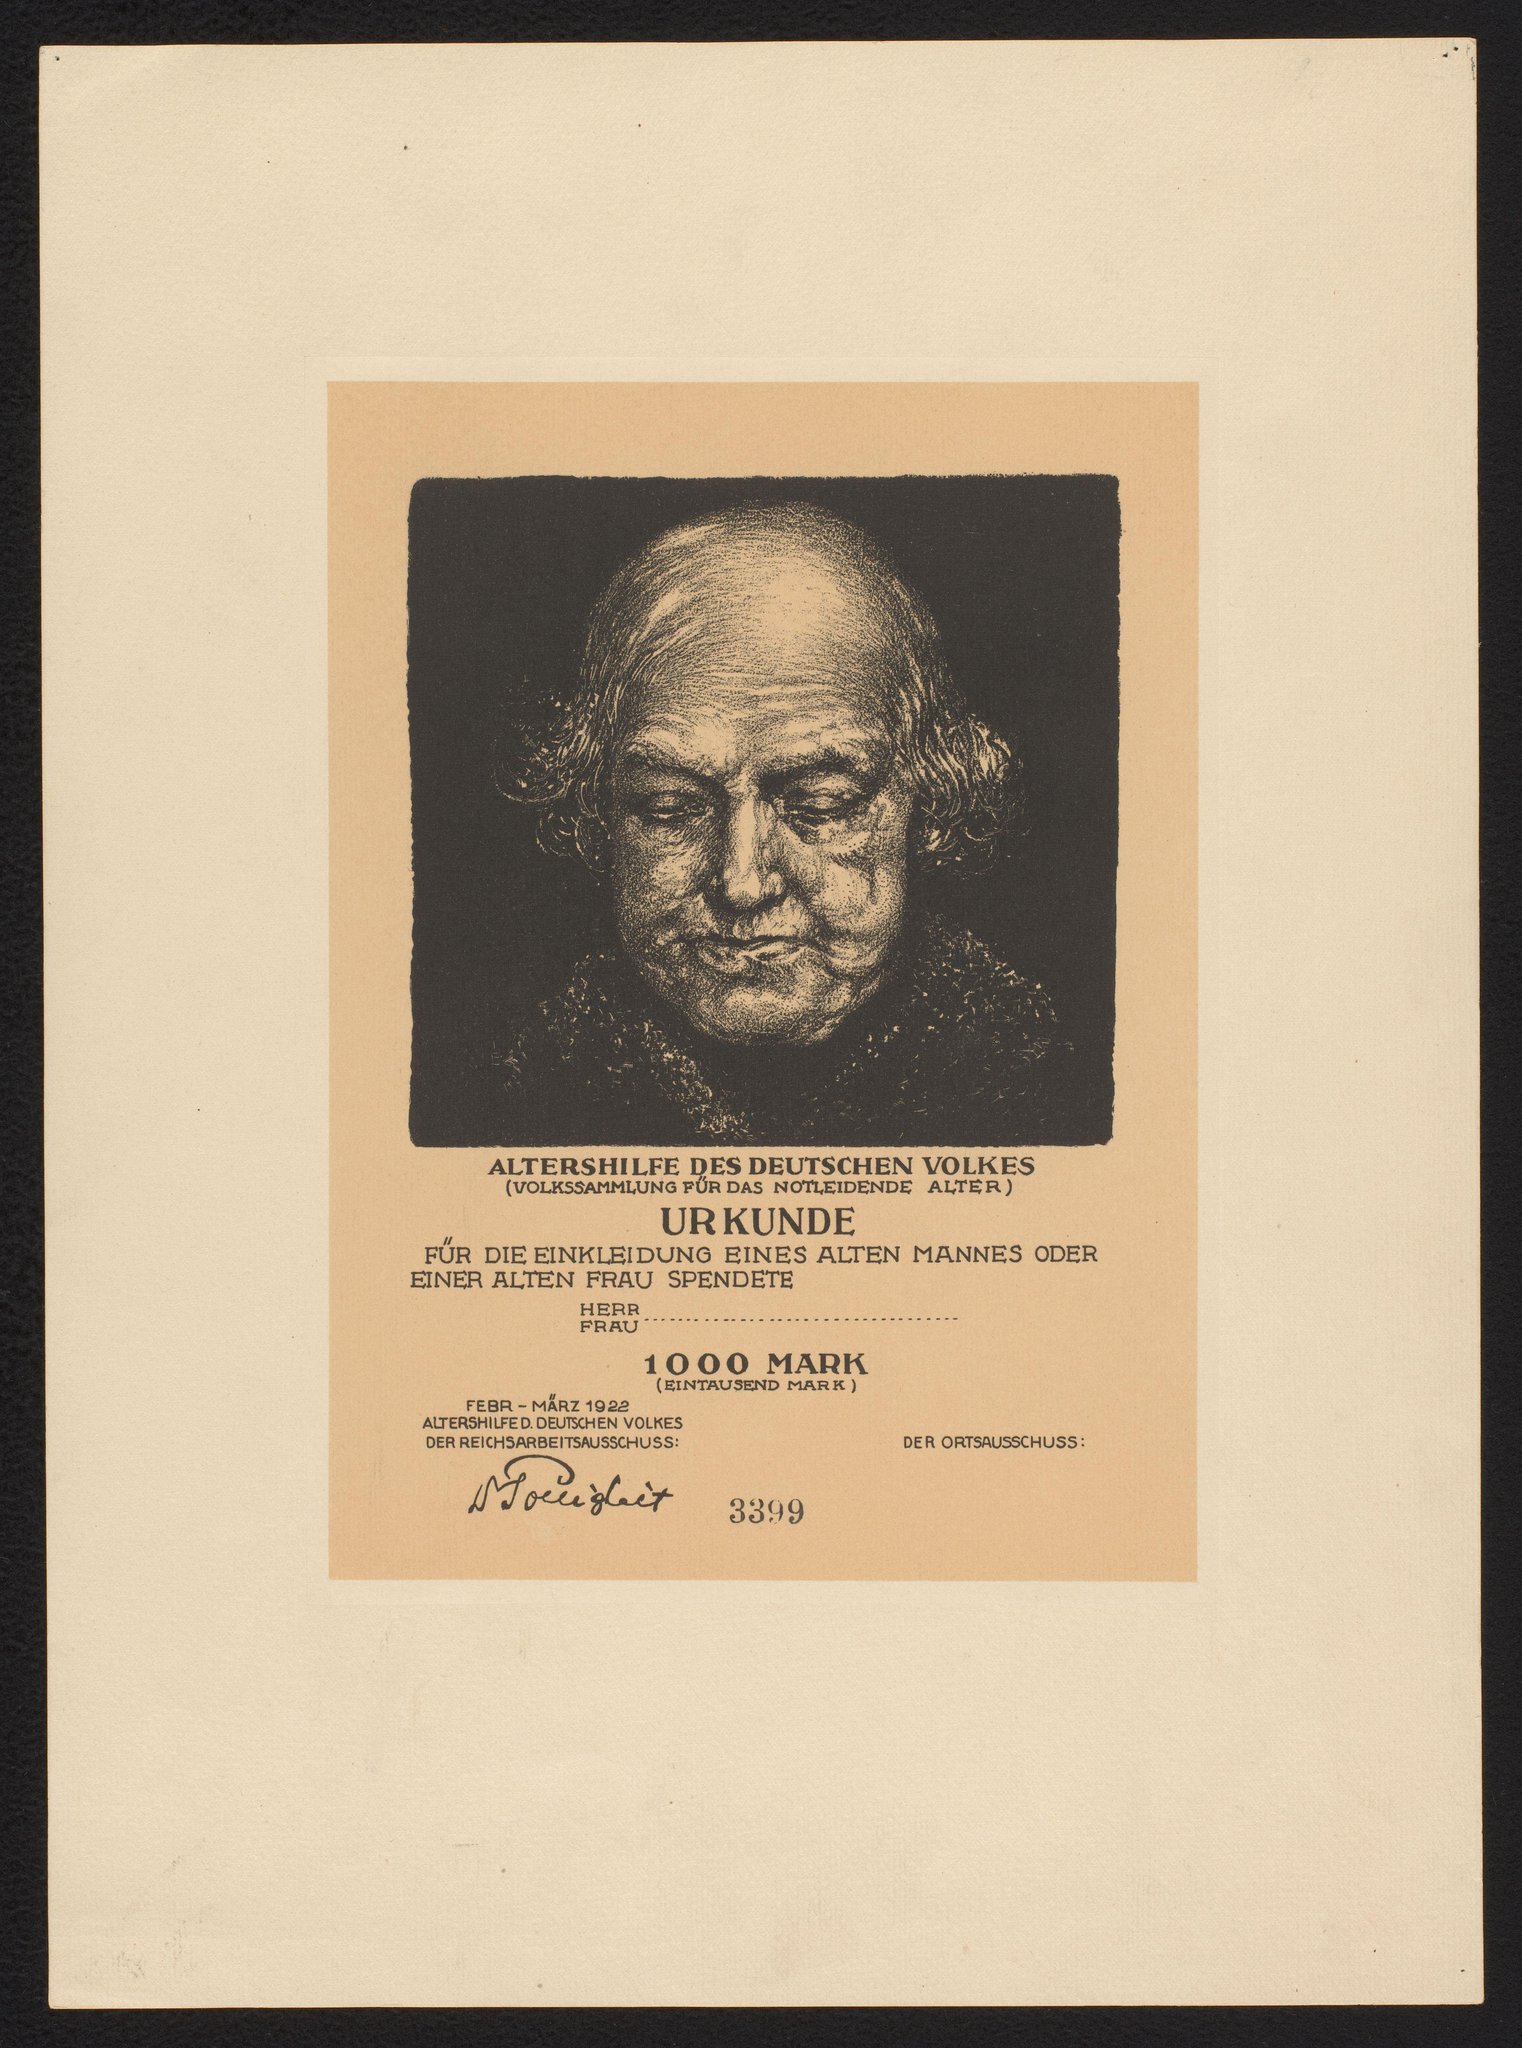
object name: print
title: Oningevulde oorkonde ten behoeve van Altershilfe des Deutsches Volkes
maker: Anonymous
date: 1902-1922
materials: paper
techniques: lithograph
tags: old man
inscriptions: number: ‘3399’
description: Portret van een oude man. Daaronder de tekst van de oorkonde, voor iemand die 1000 Mark schonk ten behoeve van de ouderenhulp in Duitsland in 1922. Volgens de tekst ('für die einkleidung eines alten Mannes oder einer alten Frau') was dit voldoende om een oude man of vrouw een jaar lang te kleden. Deze inzamelingsactie voor noodlijdende ouderen werd in februari - maart 1922 georganiseerd door de Reichsarbeitsausschuss.